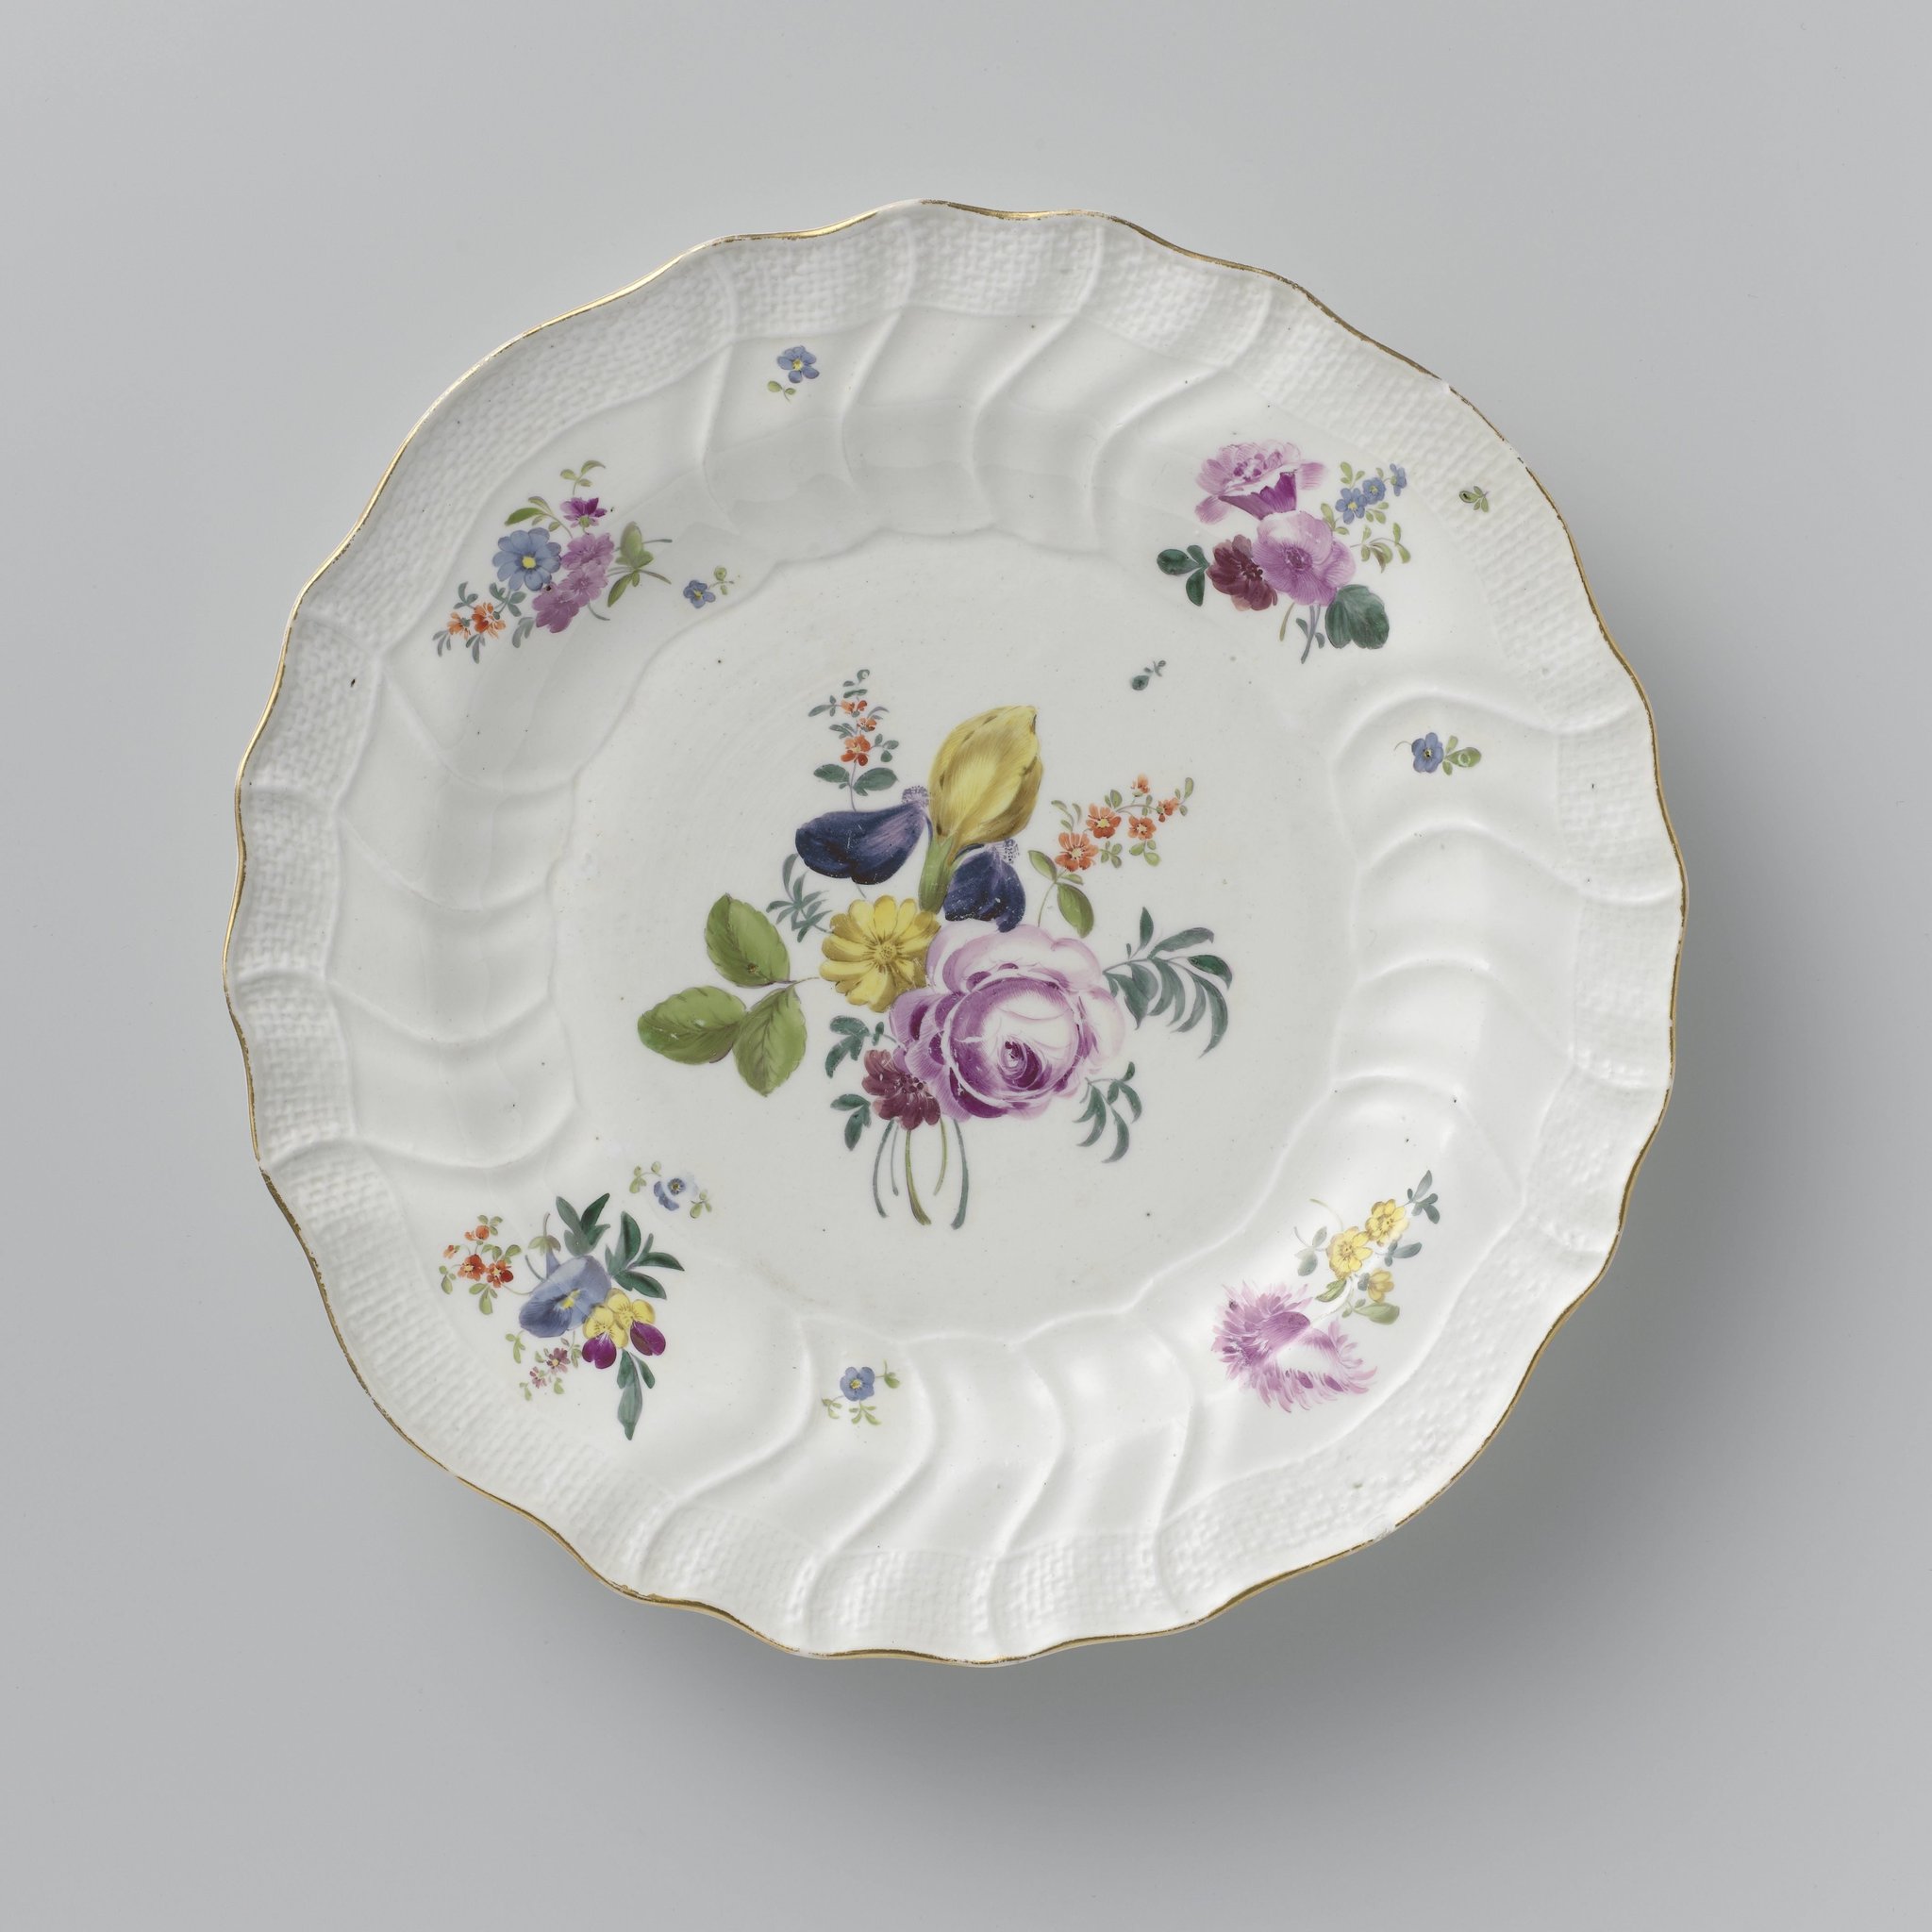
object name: plate dish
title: Bord, veelkleurig beschilderd met Deutsche Blumen, insekten en vruchten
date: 1750-1760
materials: porcelain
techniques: painted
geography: meissen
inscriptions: factory mark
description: Rond bord van beschilderd porselein. Het bord is beschilderd met Deutsche Blumen, insekten en vruchten. De rand is in reliëf versierd met het Neuozier-patroon. Het bord is gemerkt en hoort bij een servies (BK-17474-1 t/m BK-17474-253).